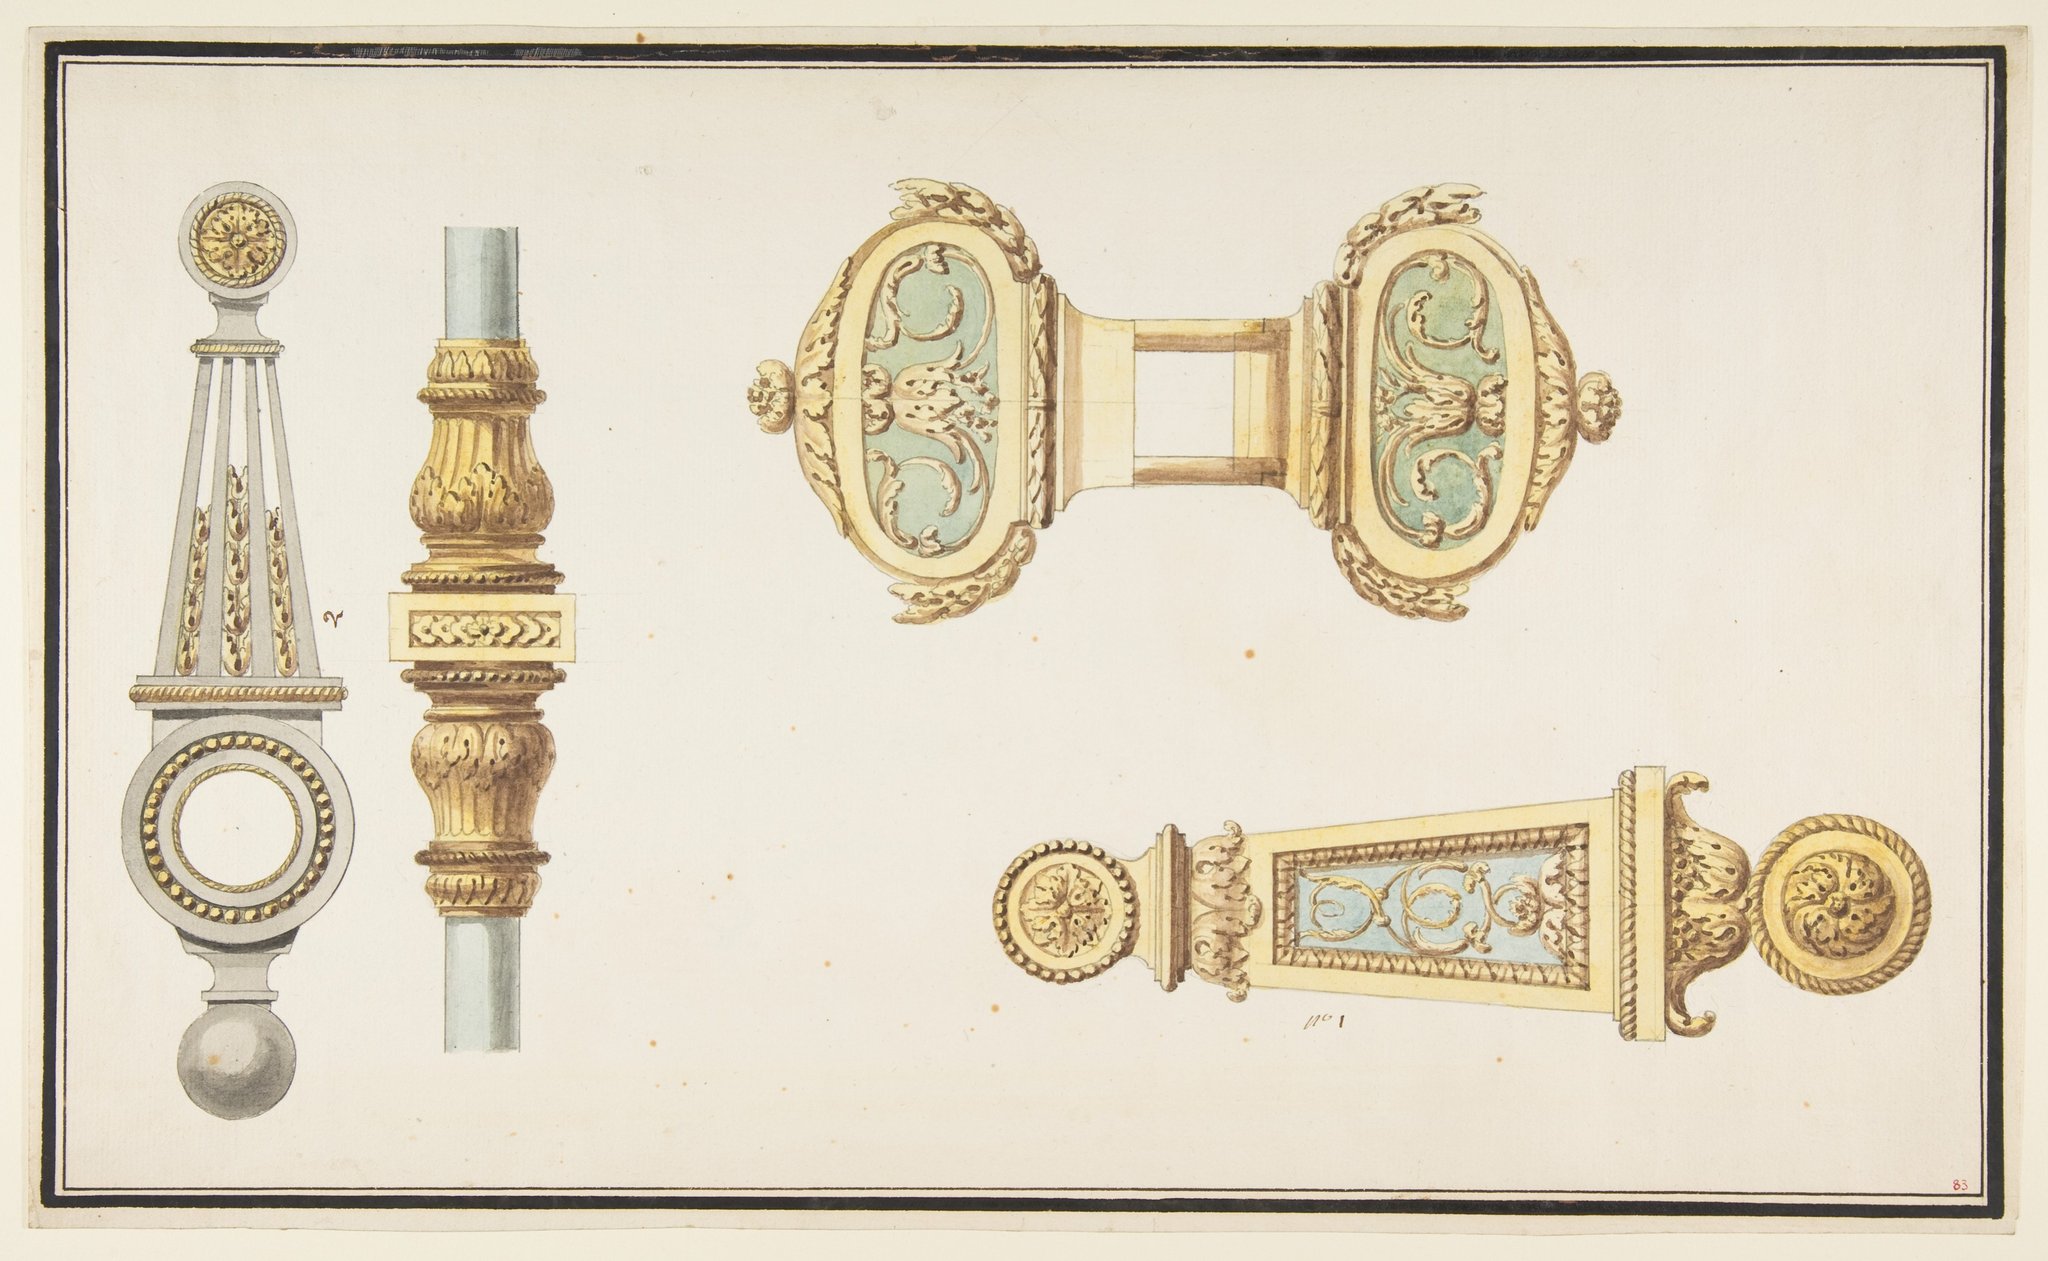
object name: drawing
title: Designs for Door Hardware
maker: anonymous, french, 18th century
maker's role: artist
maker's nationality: french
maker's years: 1700-1800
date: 1775-1785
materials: graphite, ink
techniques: brush, pen, wash